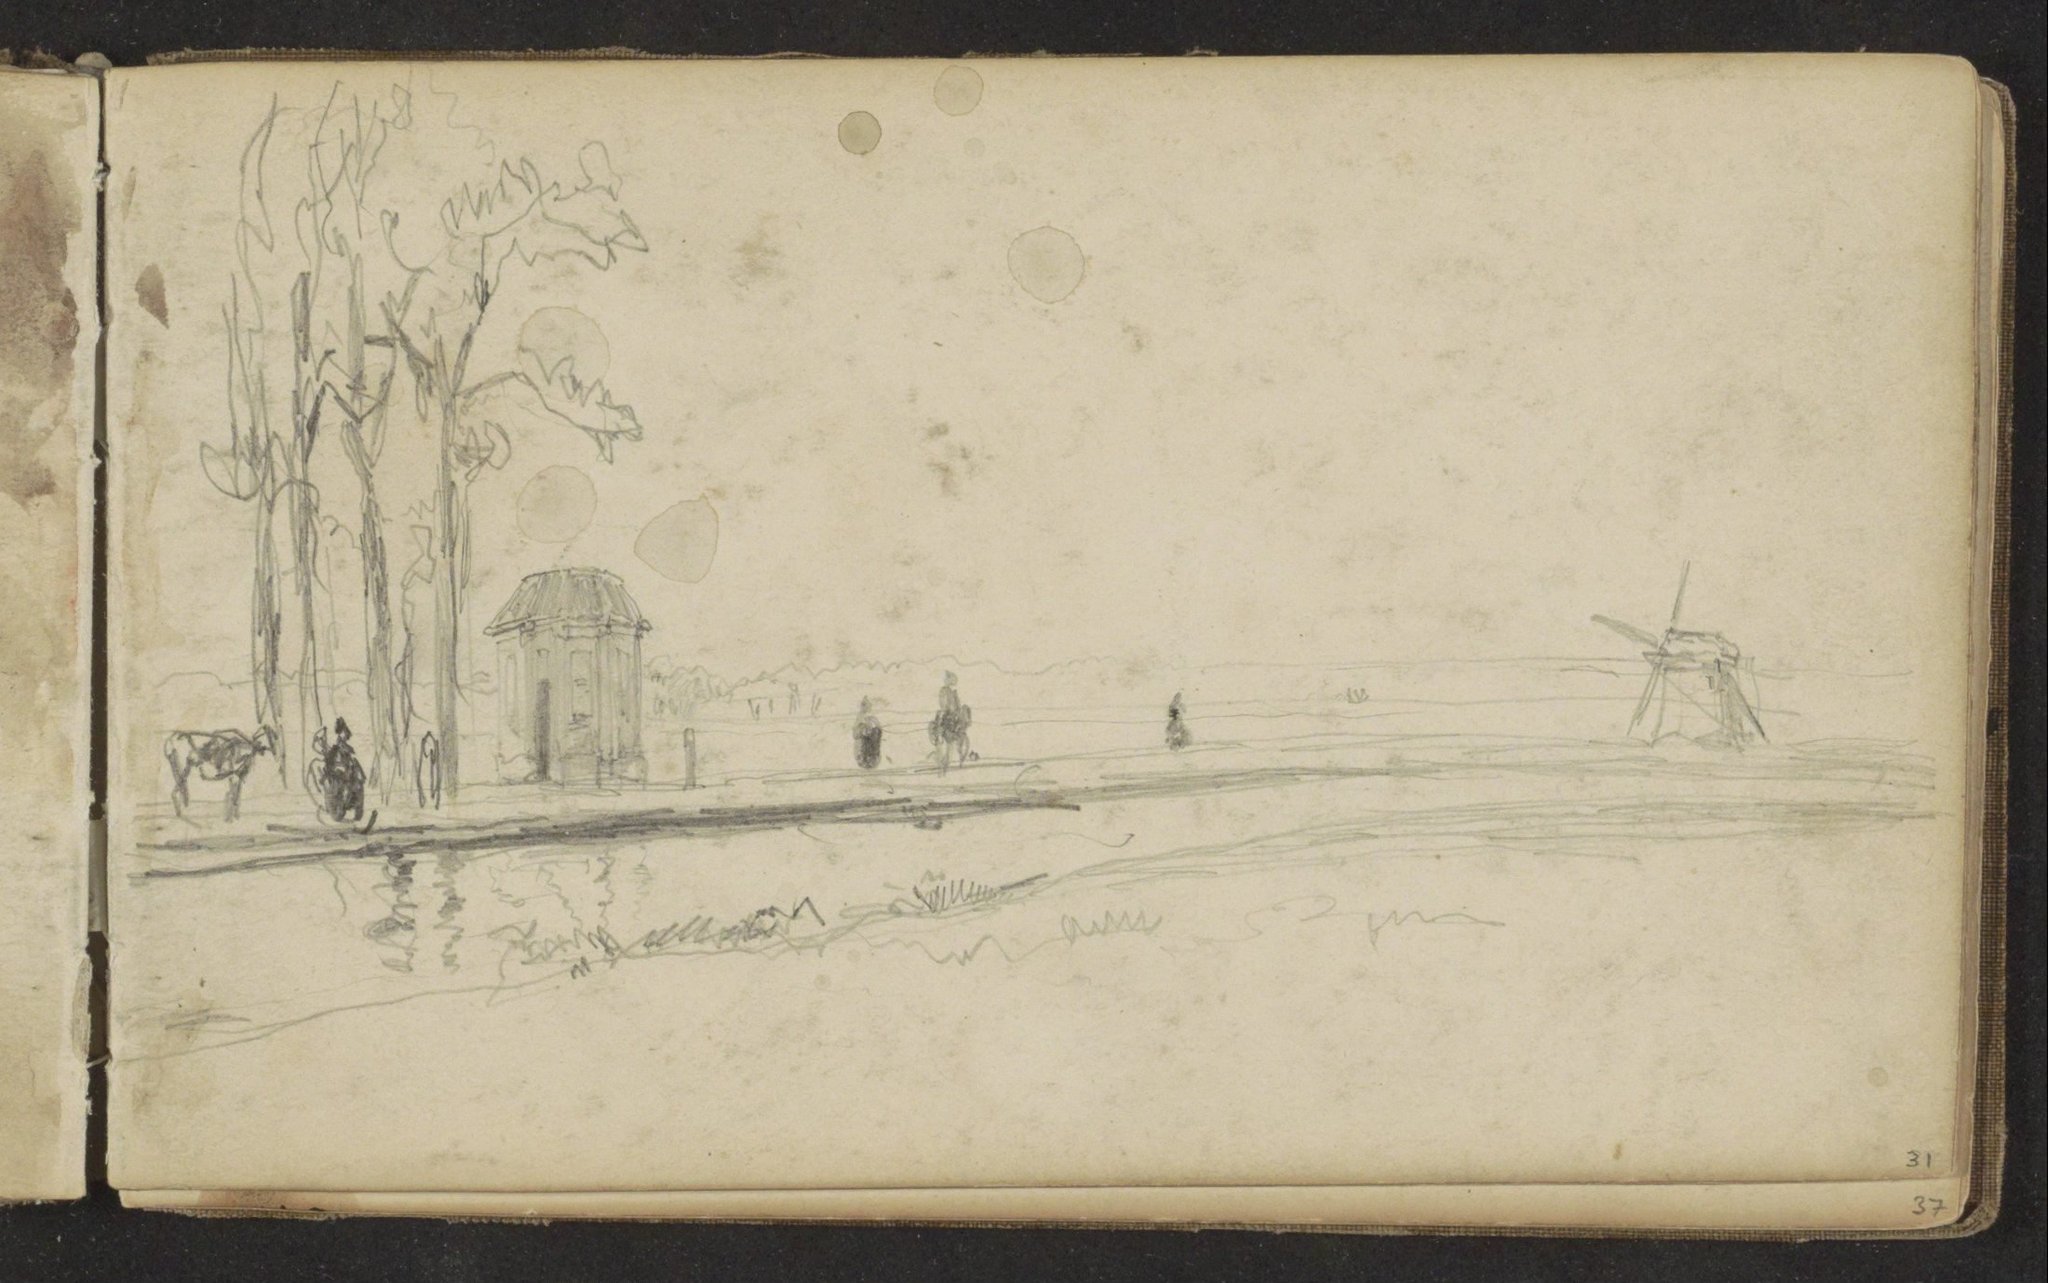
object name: sketchbook leaf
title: Theekoepel van Cromvliet aan de Vliet bij Rijswijk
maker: johan hendrik weissenbruch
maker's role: draughtsman, painter, print maker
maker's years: 1824-1903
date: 1834-1903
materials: paper, pencil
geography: rijswijk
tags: summer-house, arbour, garden-house (dutch: 'theekoepel'), landscapes with waters, waterscapes, seascapes (in the temperate zone) (+ landscape with figures, staffage)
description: Blad 31 recto uit een schetsboek met 43 bladen.